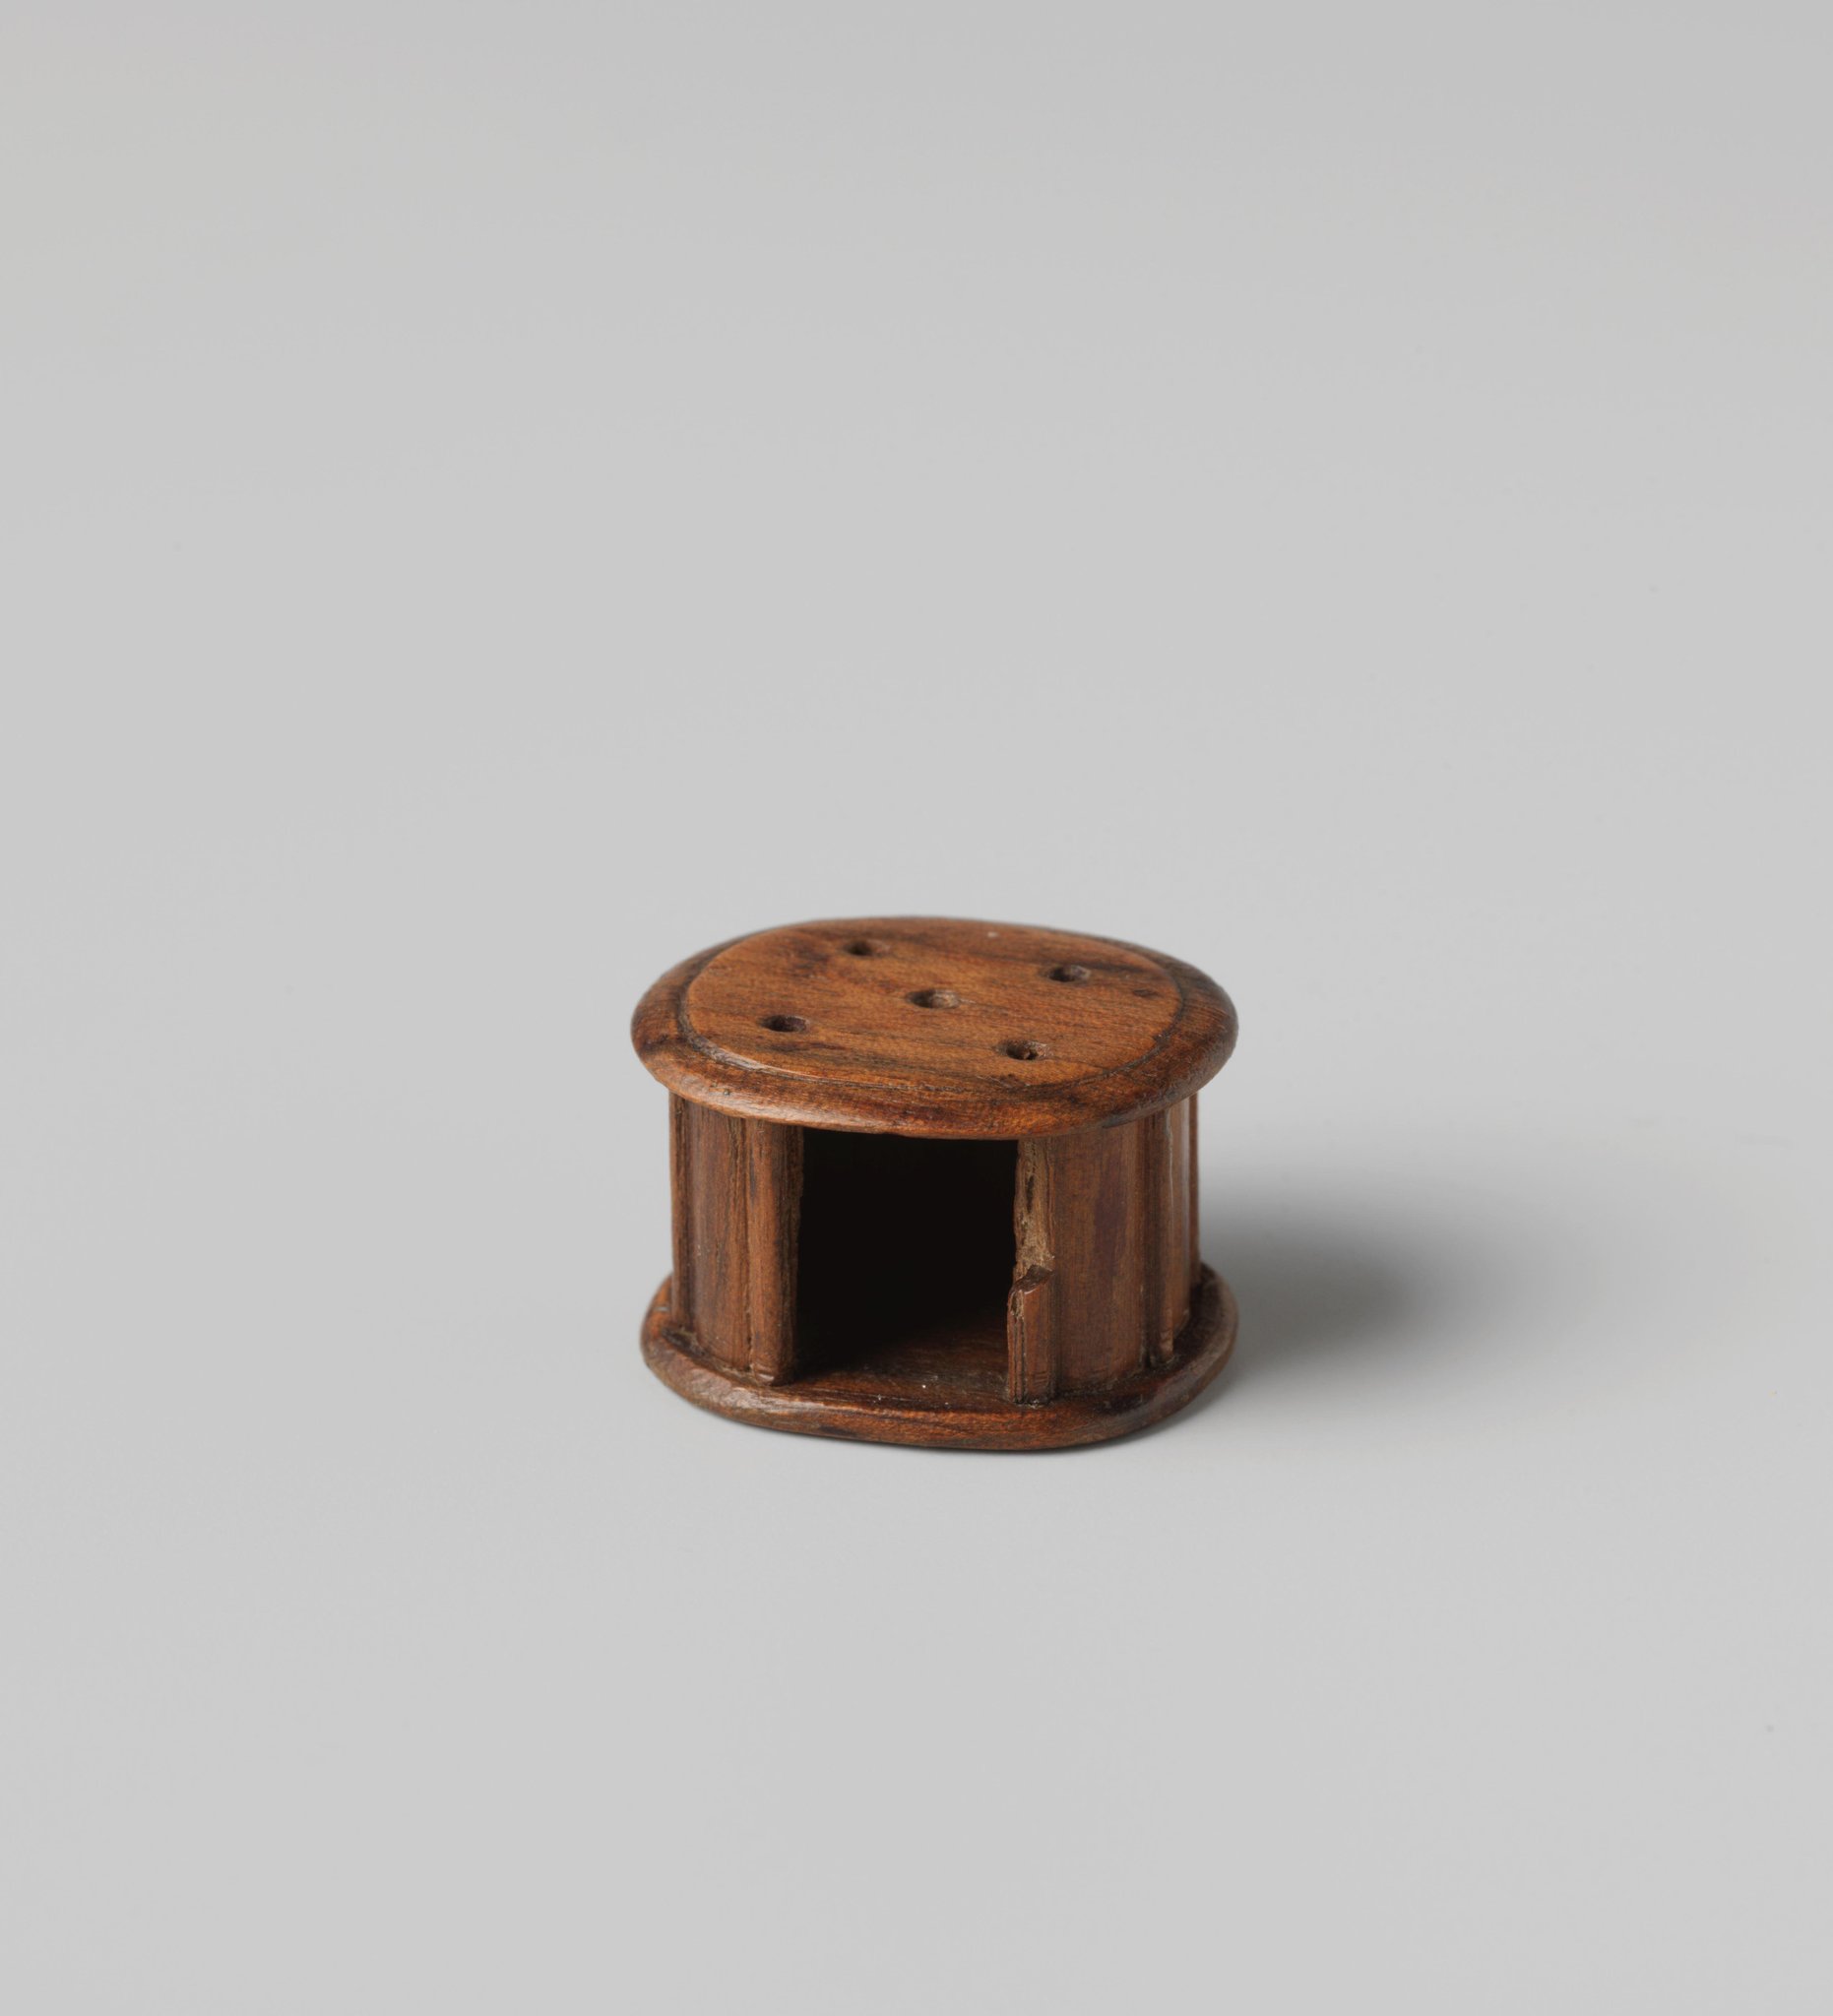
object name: furniture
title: Stoof, ovaal, met in de bovenzijde vijf gaten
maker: Anonymous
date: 1740-1760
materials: wood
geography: amsterdam